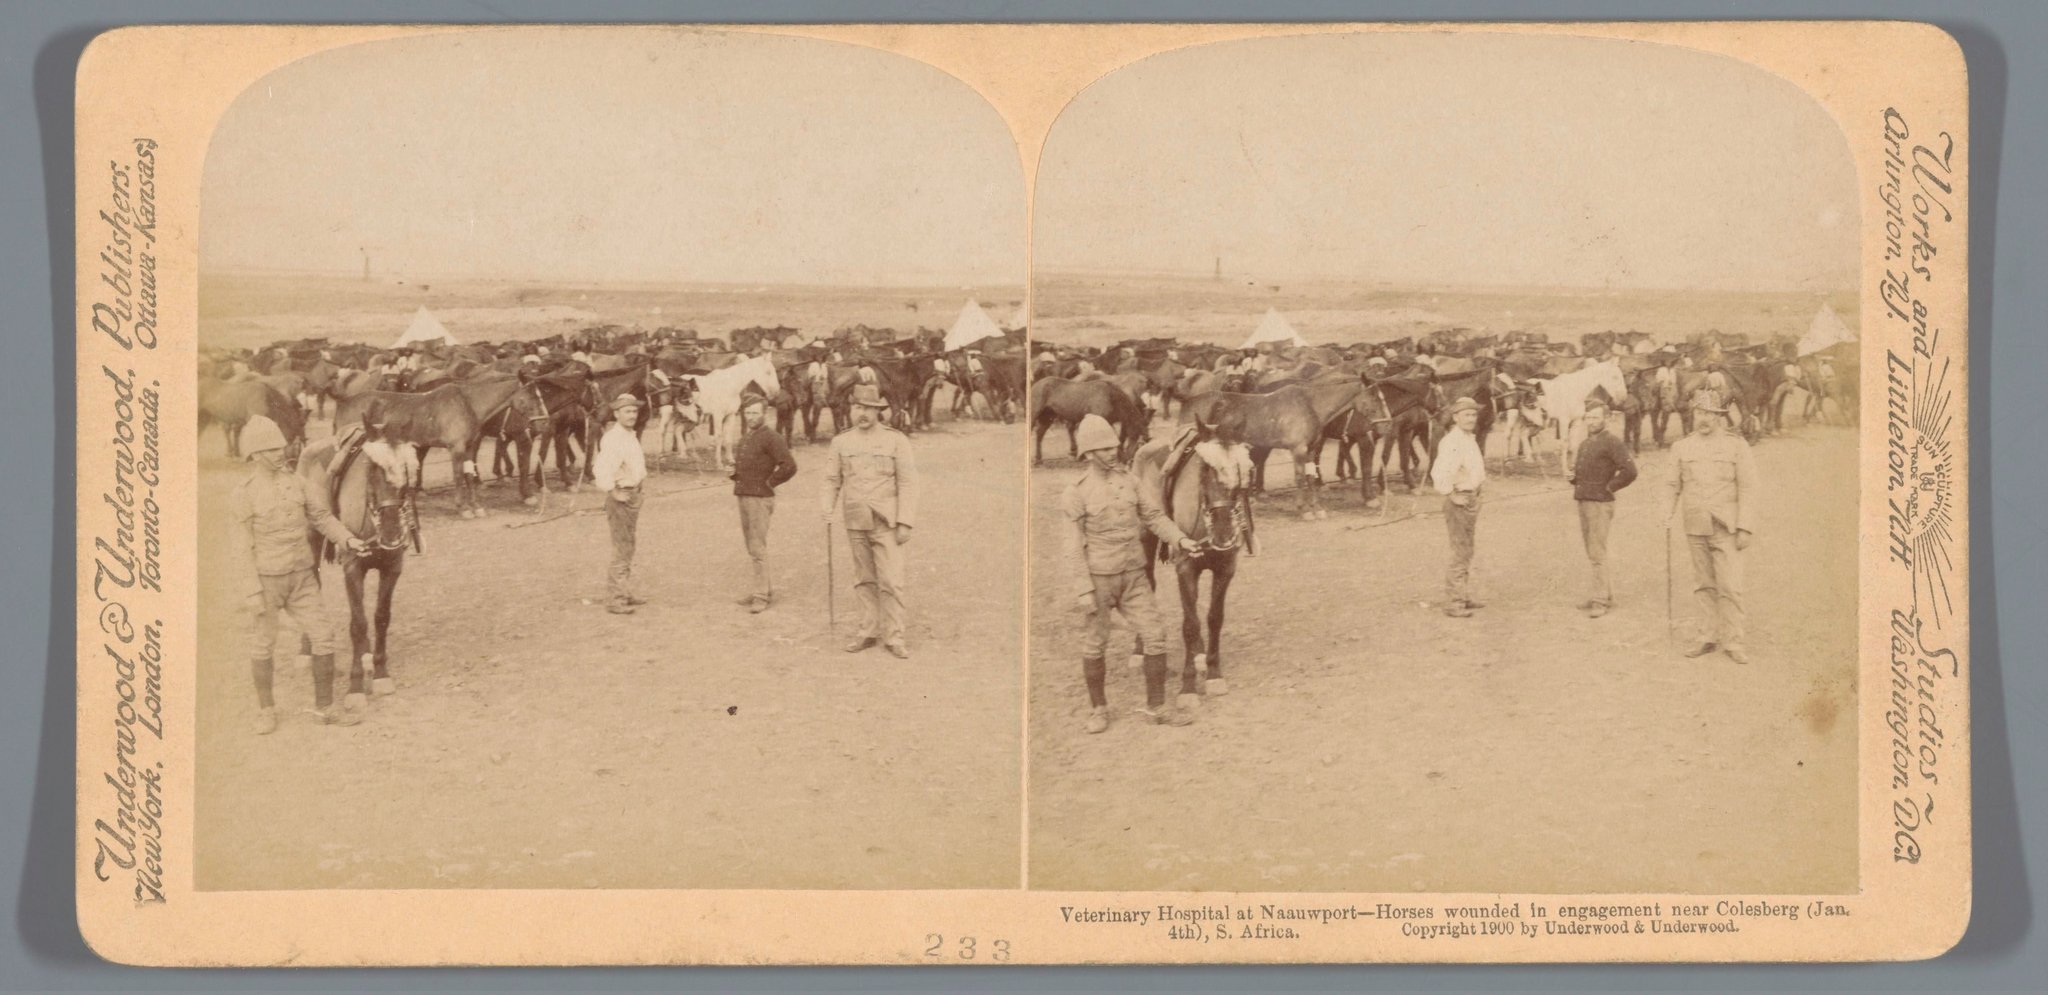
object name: stereograph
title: Veterinary Hospital at Naauwport - Horses wounded in engagement near Colesberg (Jan.4th), S. Africa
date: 1900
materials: cardboard, photographic support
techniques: albumen print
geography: south africa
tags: veterinarian, horse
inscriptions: number: ‘233’, name: ‘Works and Studios Sun Sculpture trade mark Arlington N.J. Littleton N.H. Washington D.C.’